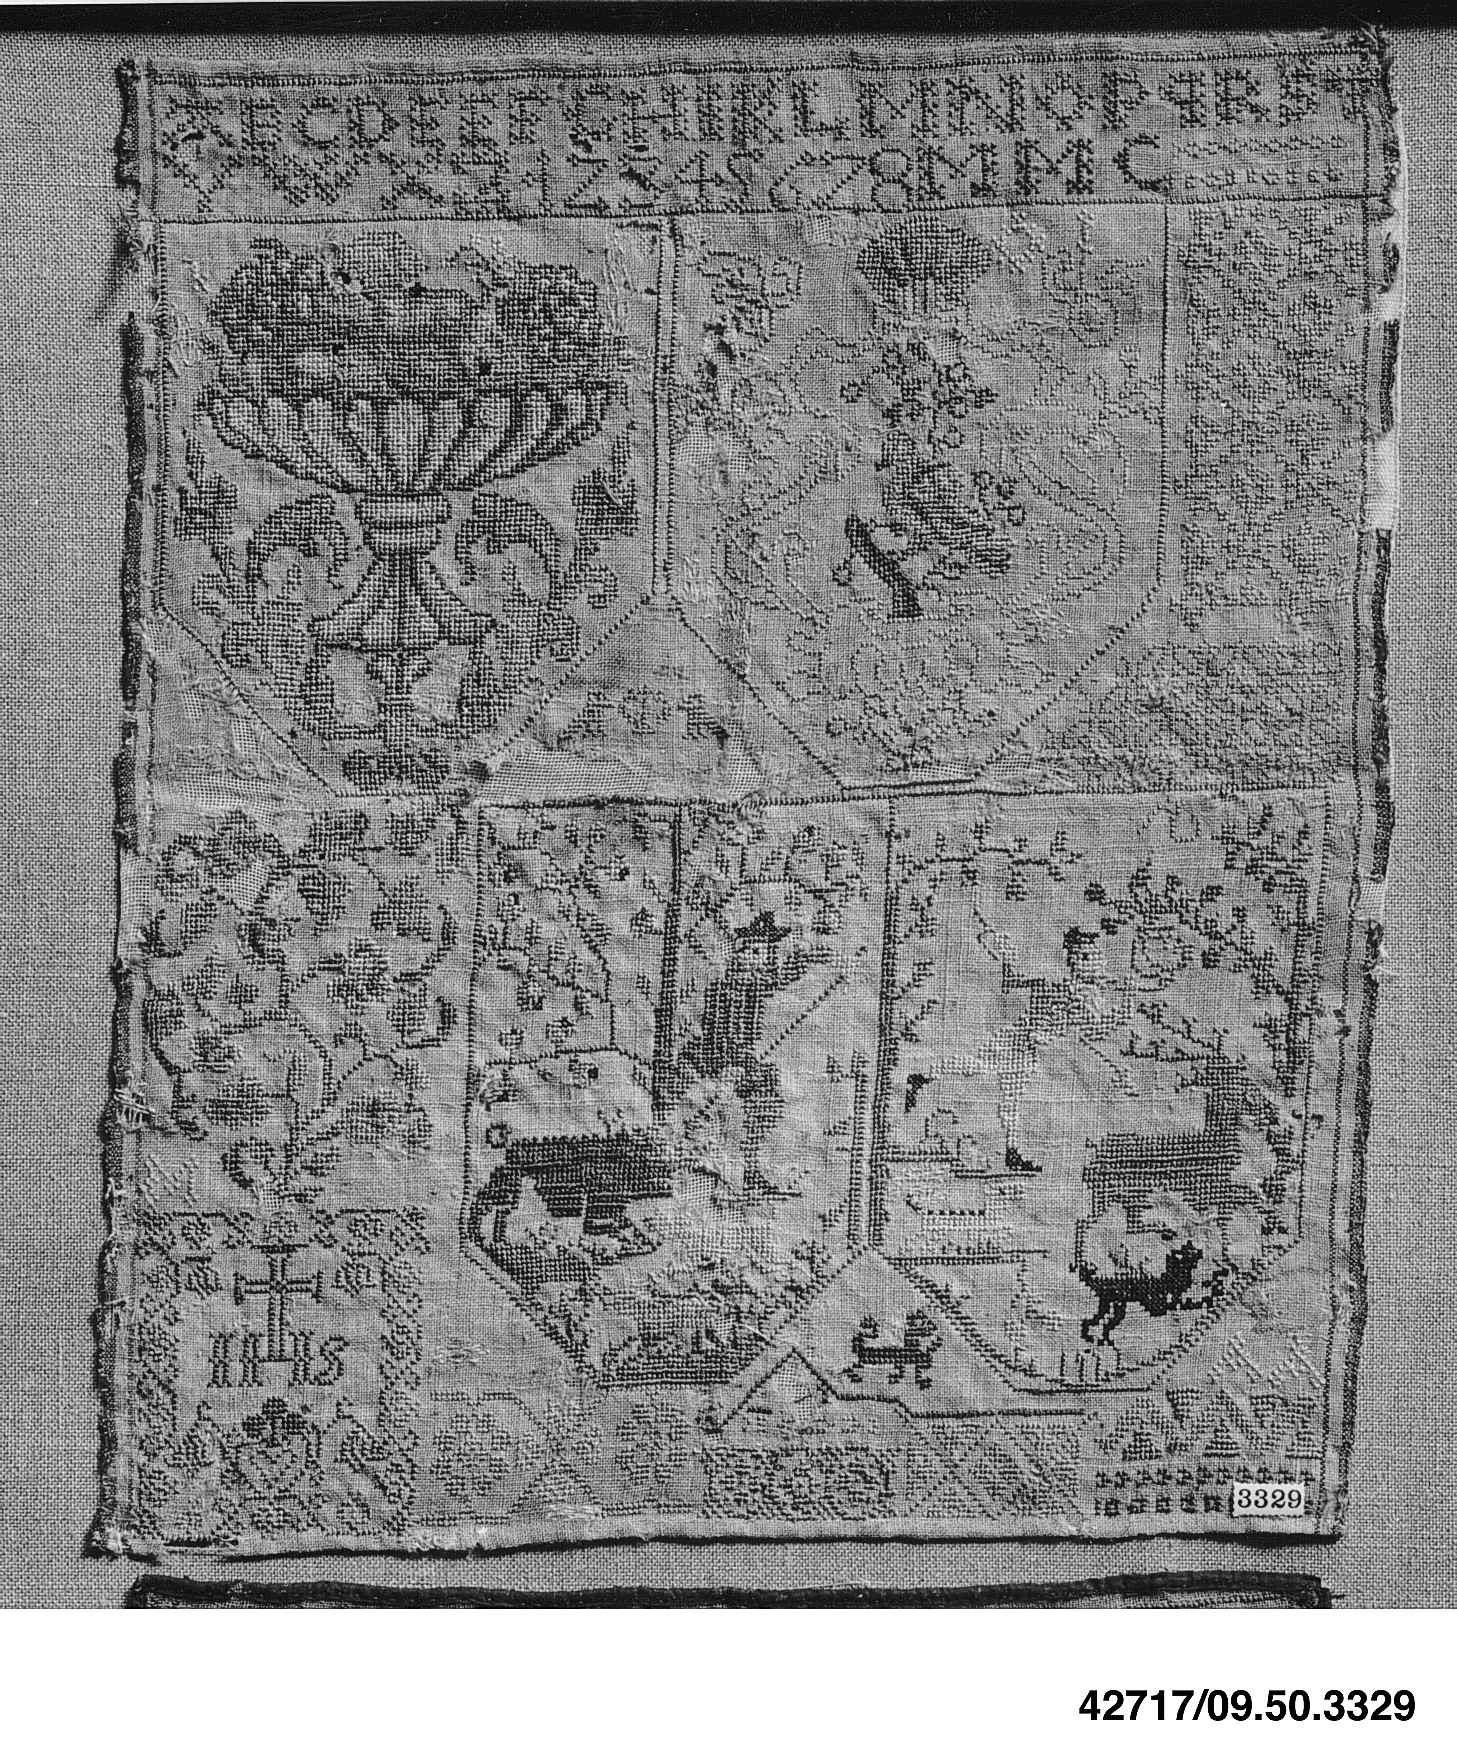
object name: sampler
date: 1701-1800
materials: linen, silk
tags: animals,men,cross